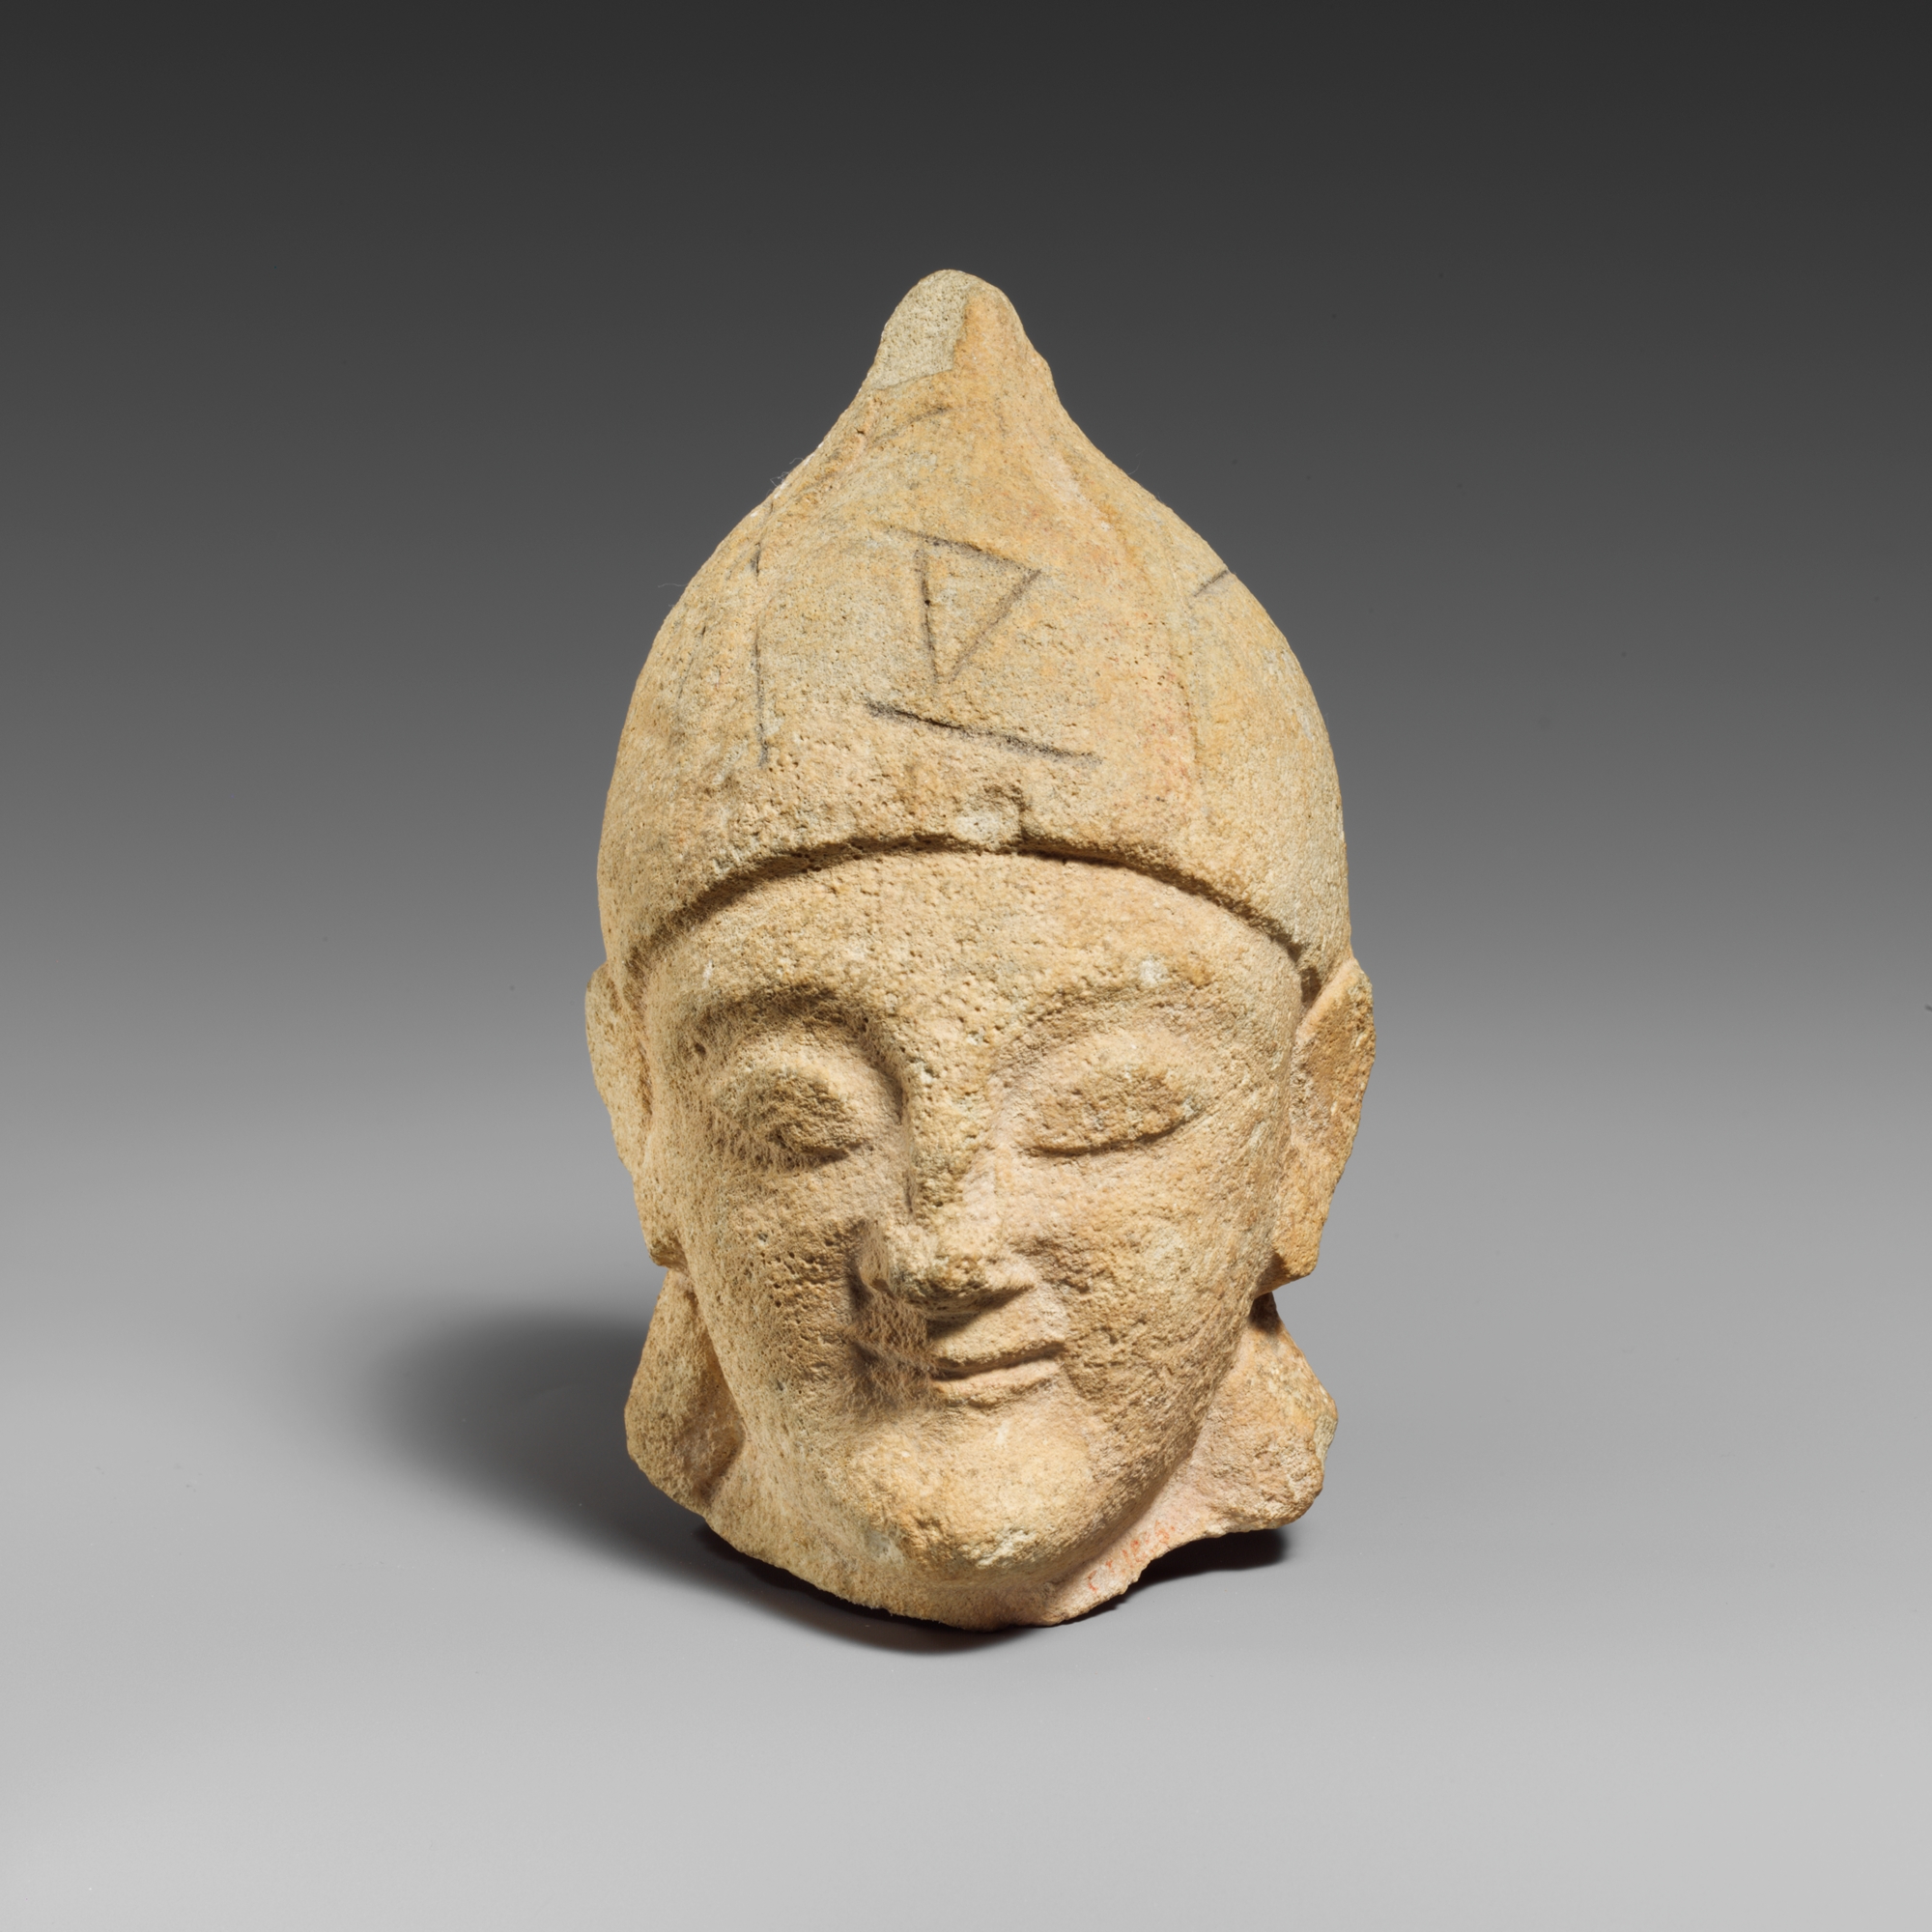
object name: head of a votary, inscribed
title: Limestone head of a beardless male with a helmet of Greek type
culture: cypriot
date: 400-301 BCE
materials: limestone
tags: heads,men